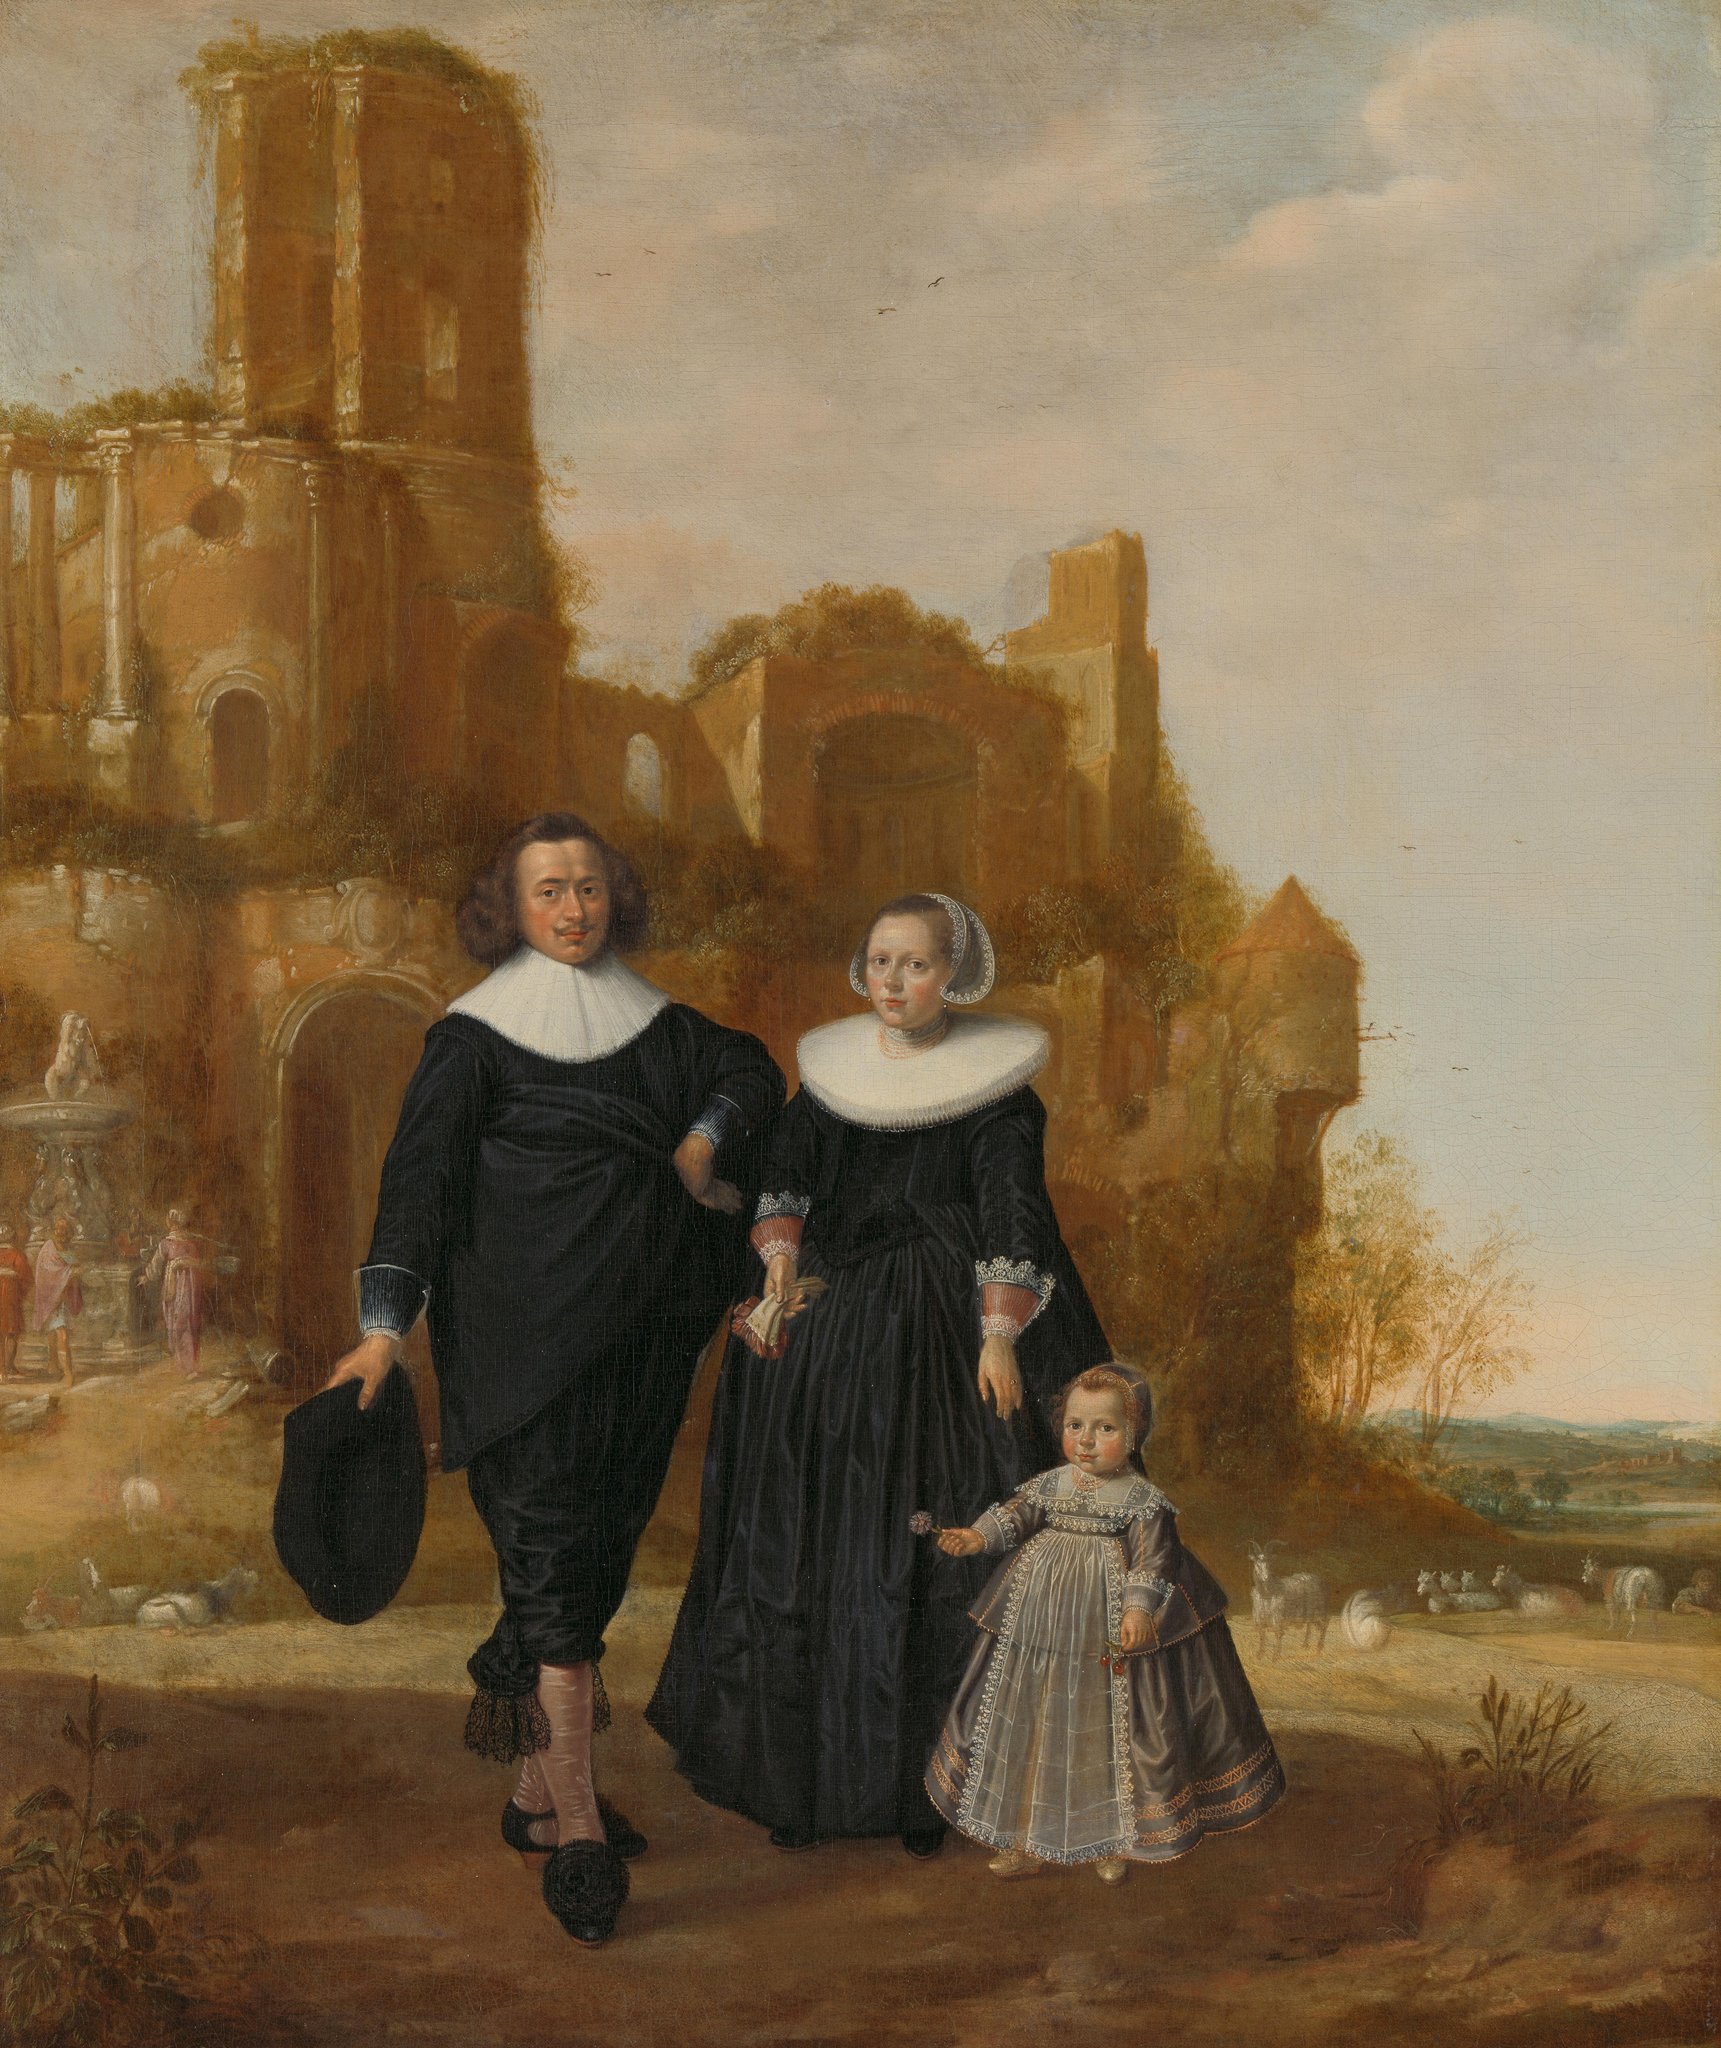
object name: painting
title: Portrait of a Couple with their Child in a Landscape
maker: herman meynderts doncker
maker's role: painter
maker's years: 1595-1656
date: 1620-1656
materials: canvas, oil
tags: family group, especially parents with their child(ren), landscape with ruins, anonymous historical persons portrayed in a group, in a group-portrait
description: Portret van een echtpaar met een kind. In voorname kleding, staande in een landschap voor de ruïne van een antiek bouwwerk. Op de achtergrond links een fontein, rechts vee.